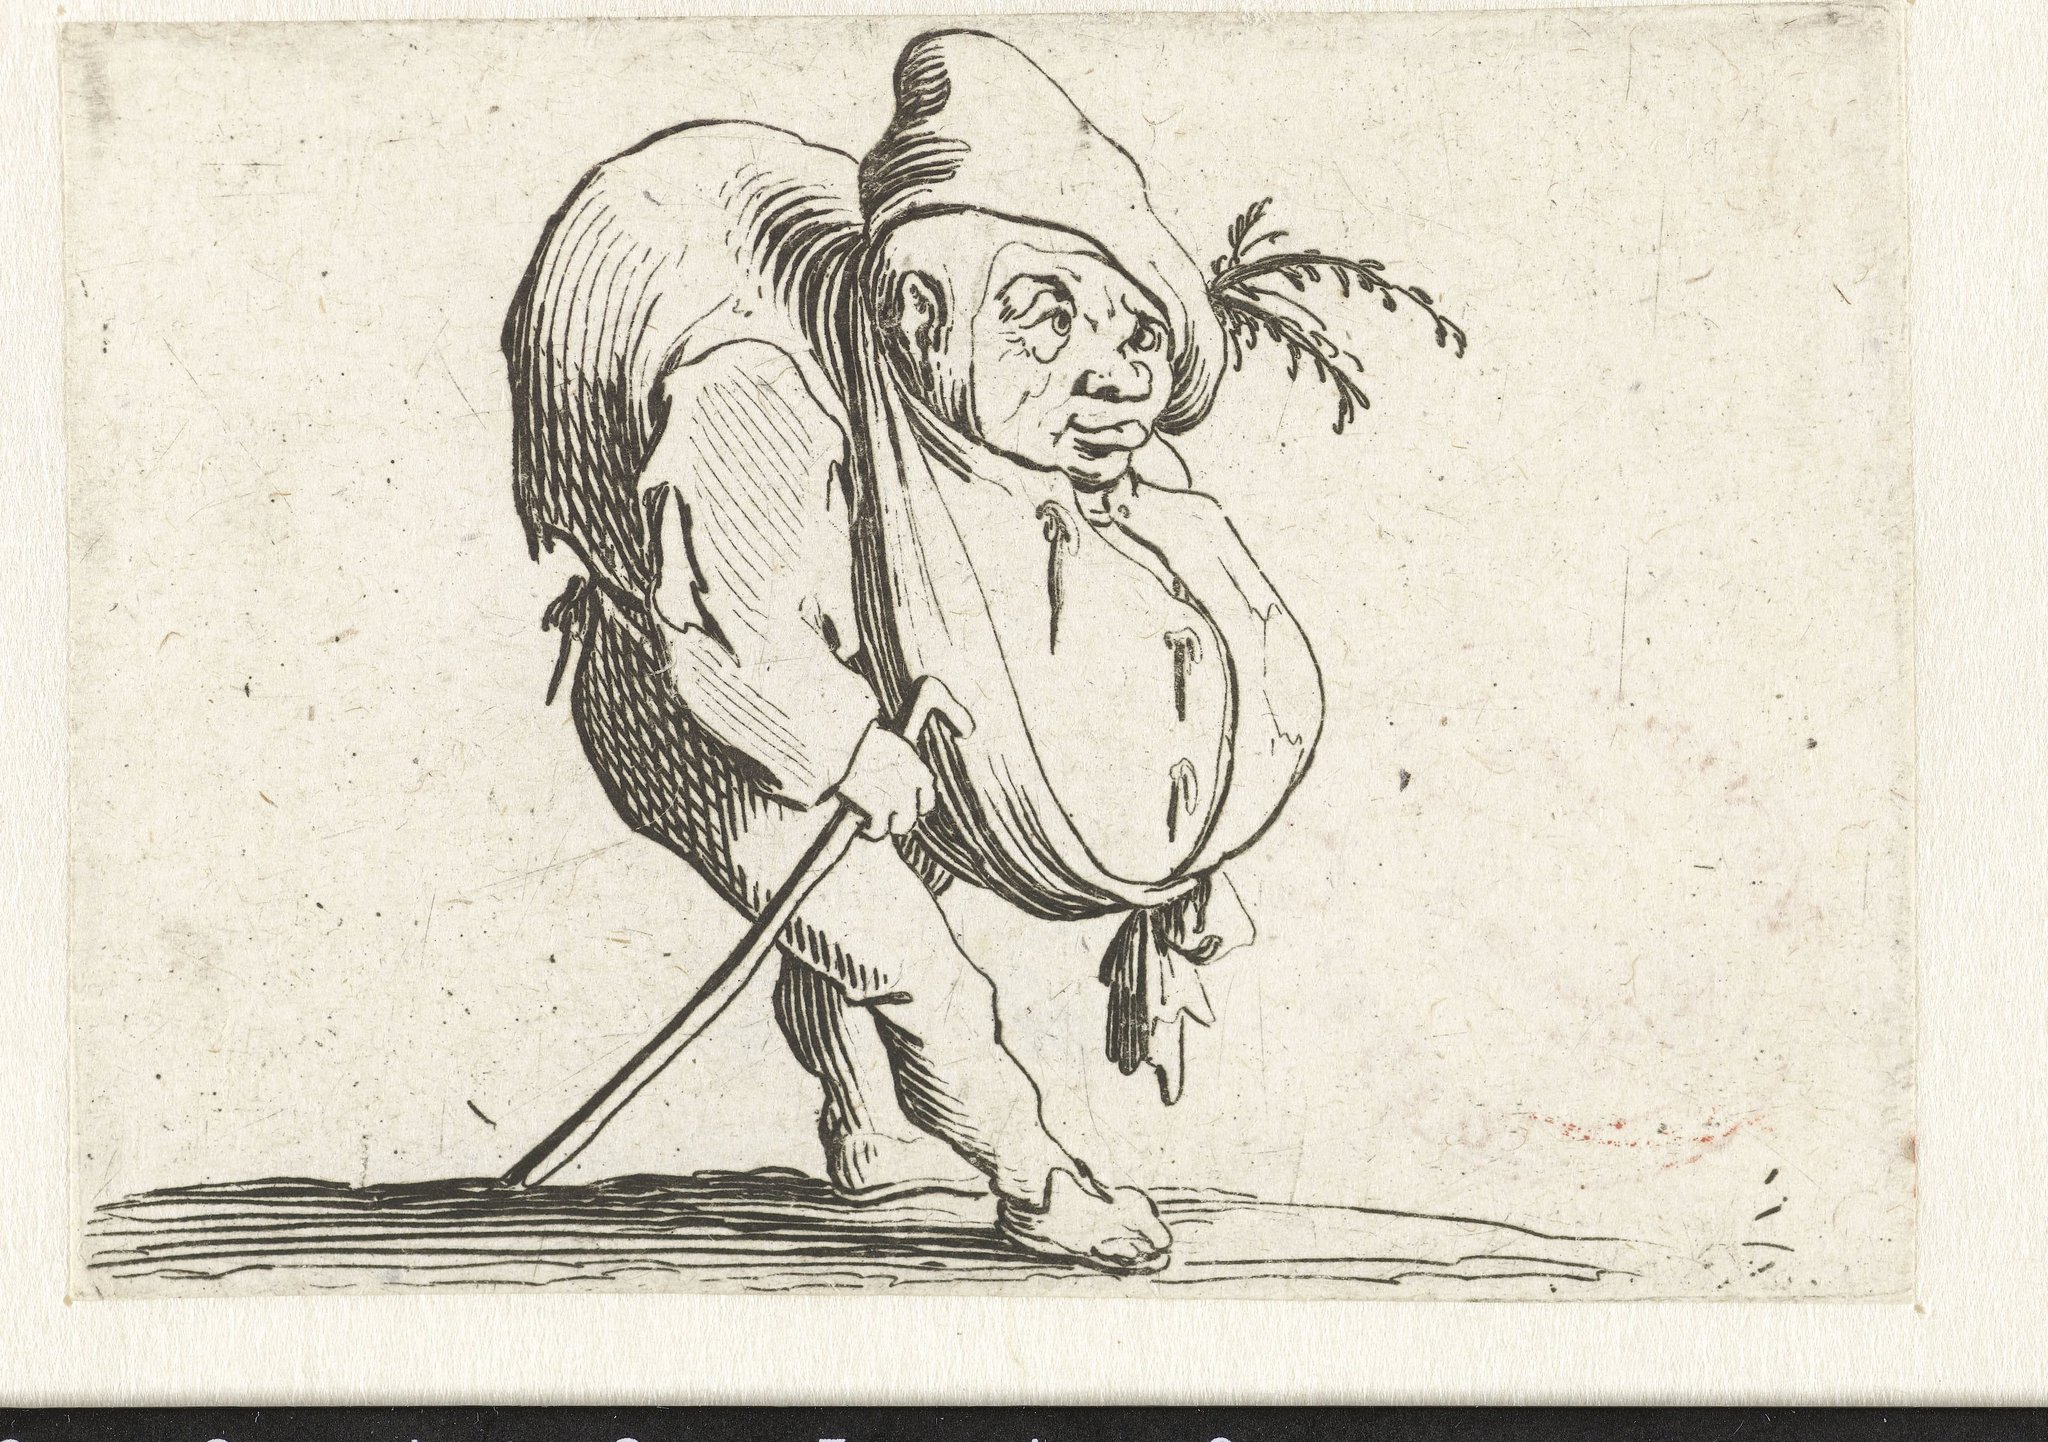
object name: print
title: Kleine mens (karikatuur) met wandelstok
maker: jacques callot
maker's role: draughtsman, print maker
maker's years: 1592-1635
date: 1621-1625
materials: paper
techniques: engraving, etching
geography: nancy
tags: little people, walking-stick, staff, hunchback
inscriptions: collector's mark: Lugt 240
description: Een kleine mens (karikatuur), op de rechterzijde gezien, met een gebochelde rug en een dikke buik of grote krop, een muts met takjes op het hoofd, een wandelstok in de rechterhand. Deze prent is onderdeel van een serie van 21 prenten met groteske figuren; vrijwel al die figuren zijn karikaturen van kleine mensen, velen zijn gebocheld.